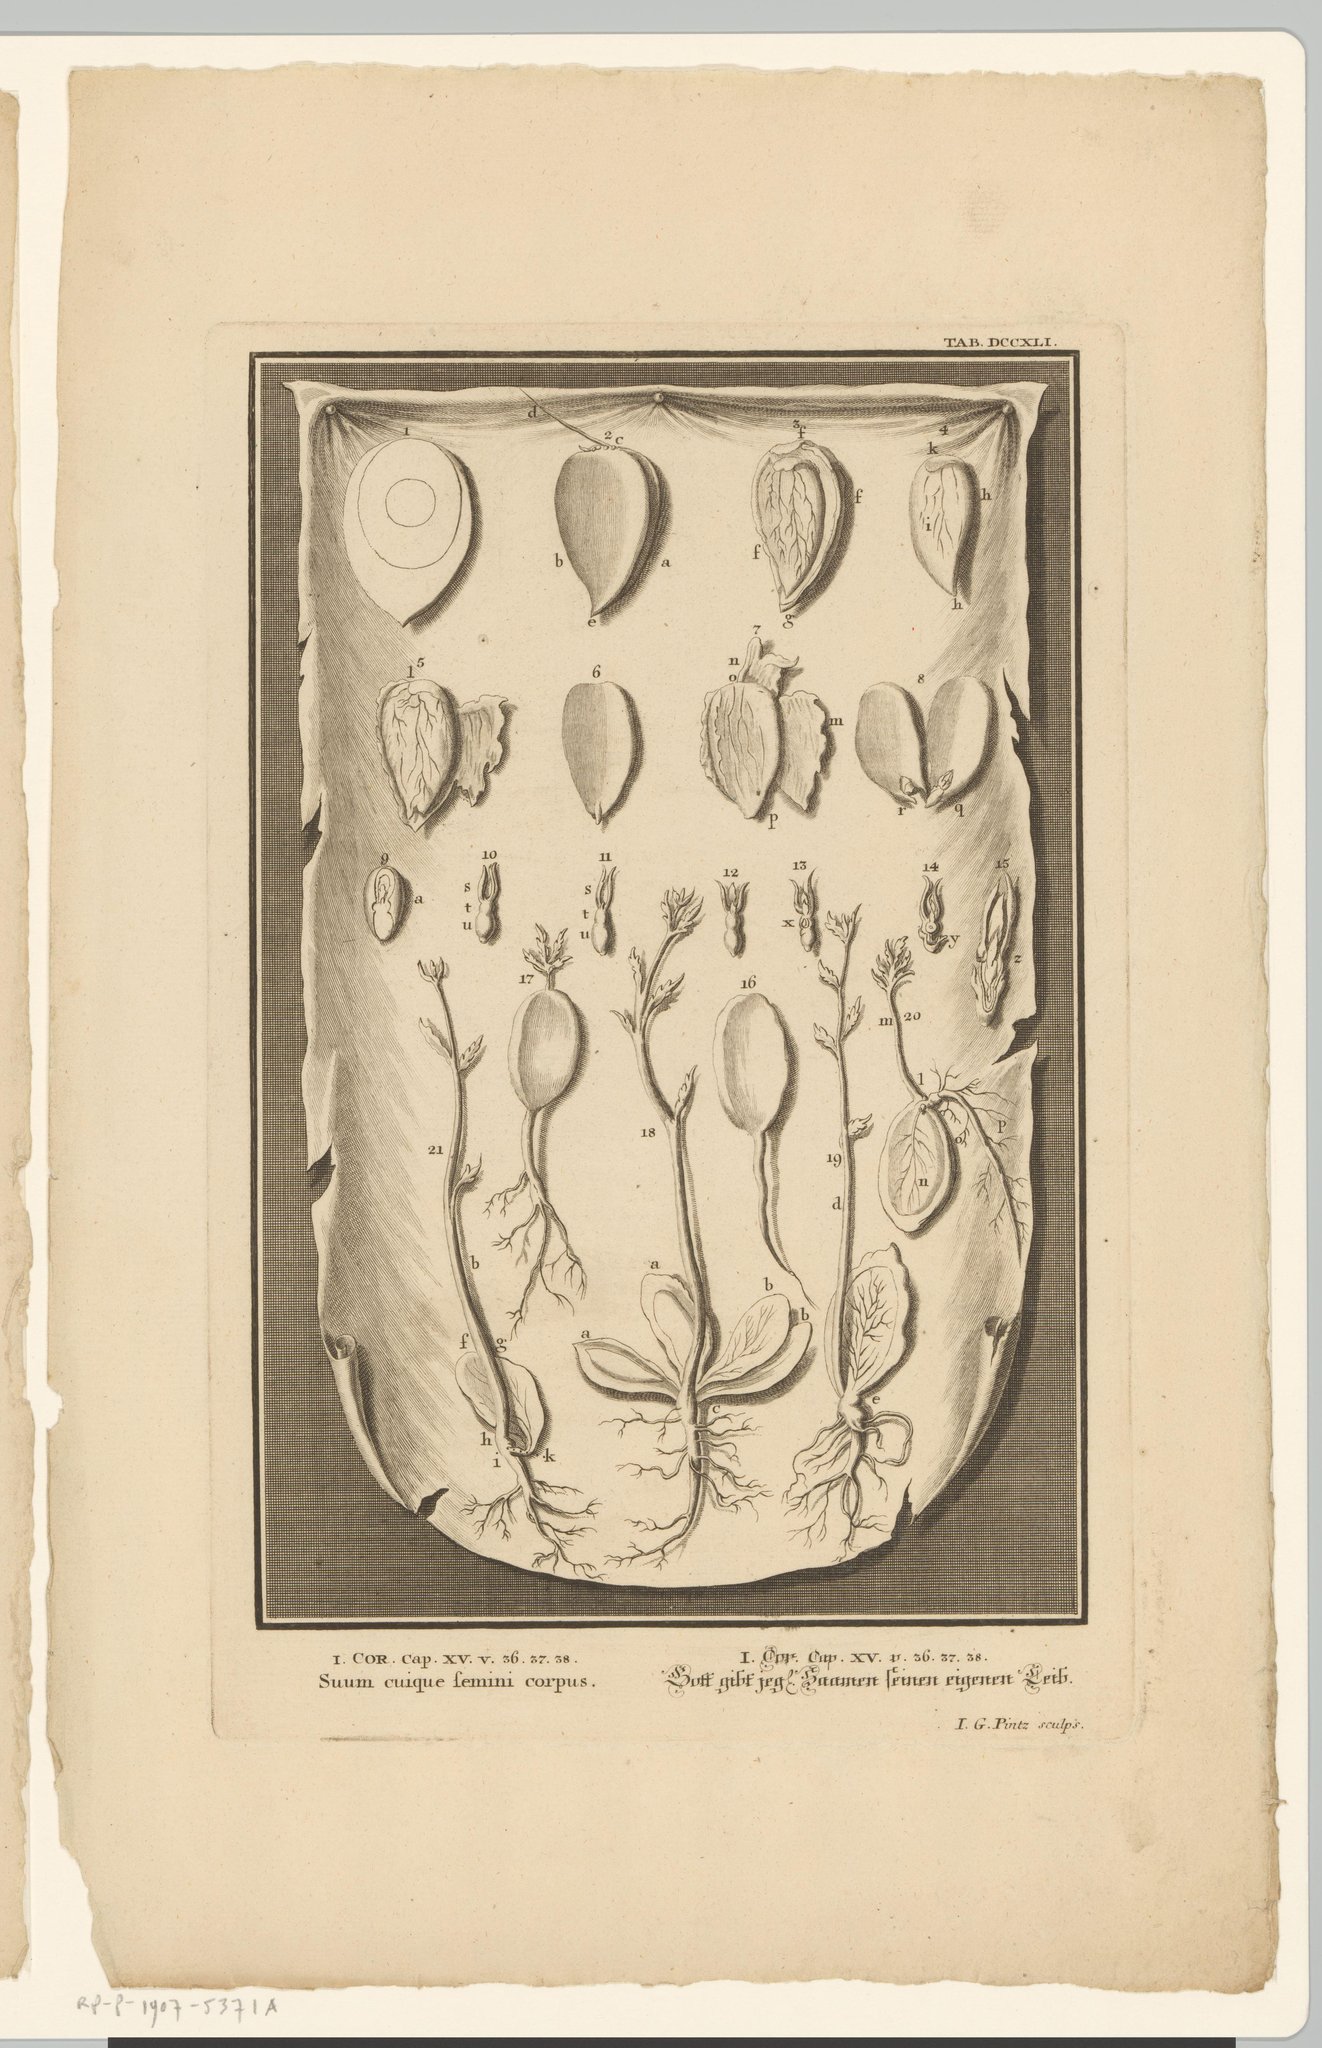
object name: print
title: Encyclopedische voorstelling van planten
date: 1733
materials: paper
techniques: engraving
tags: plants (in general)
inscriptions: collector's mark: Lugt 2228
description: Prent ook gebruikt in: Scheuchzer, Johann Jakob. Physica sacra. Augsburg: J.A. Pfeffel, 1733.